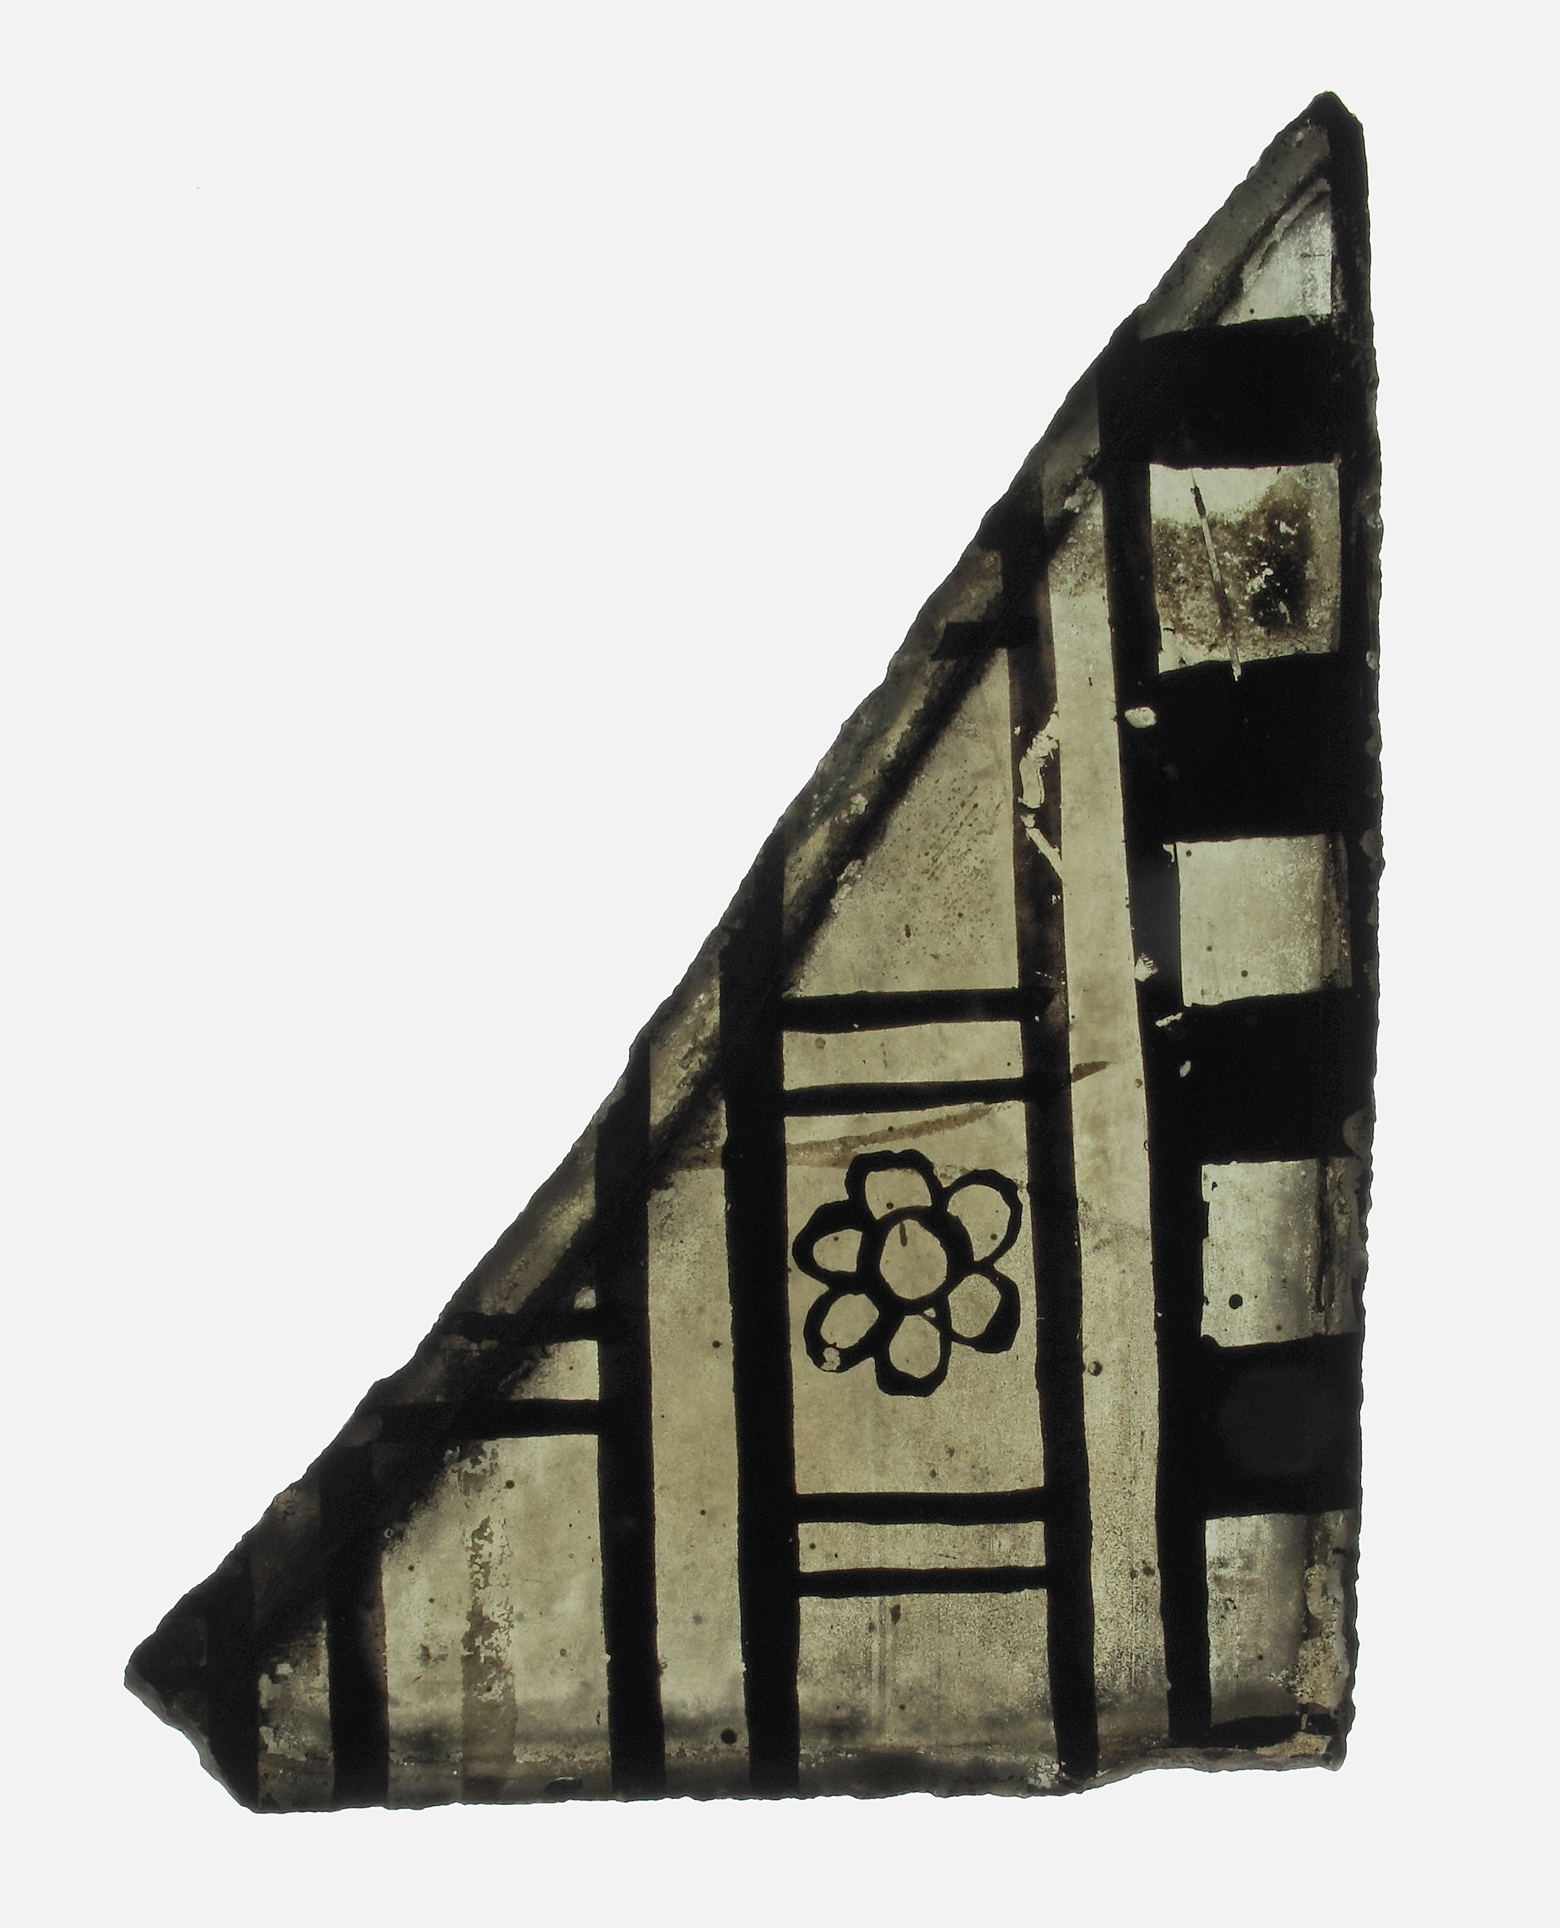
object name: fragment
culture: european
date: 1401-1500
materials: glass, metal, paint